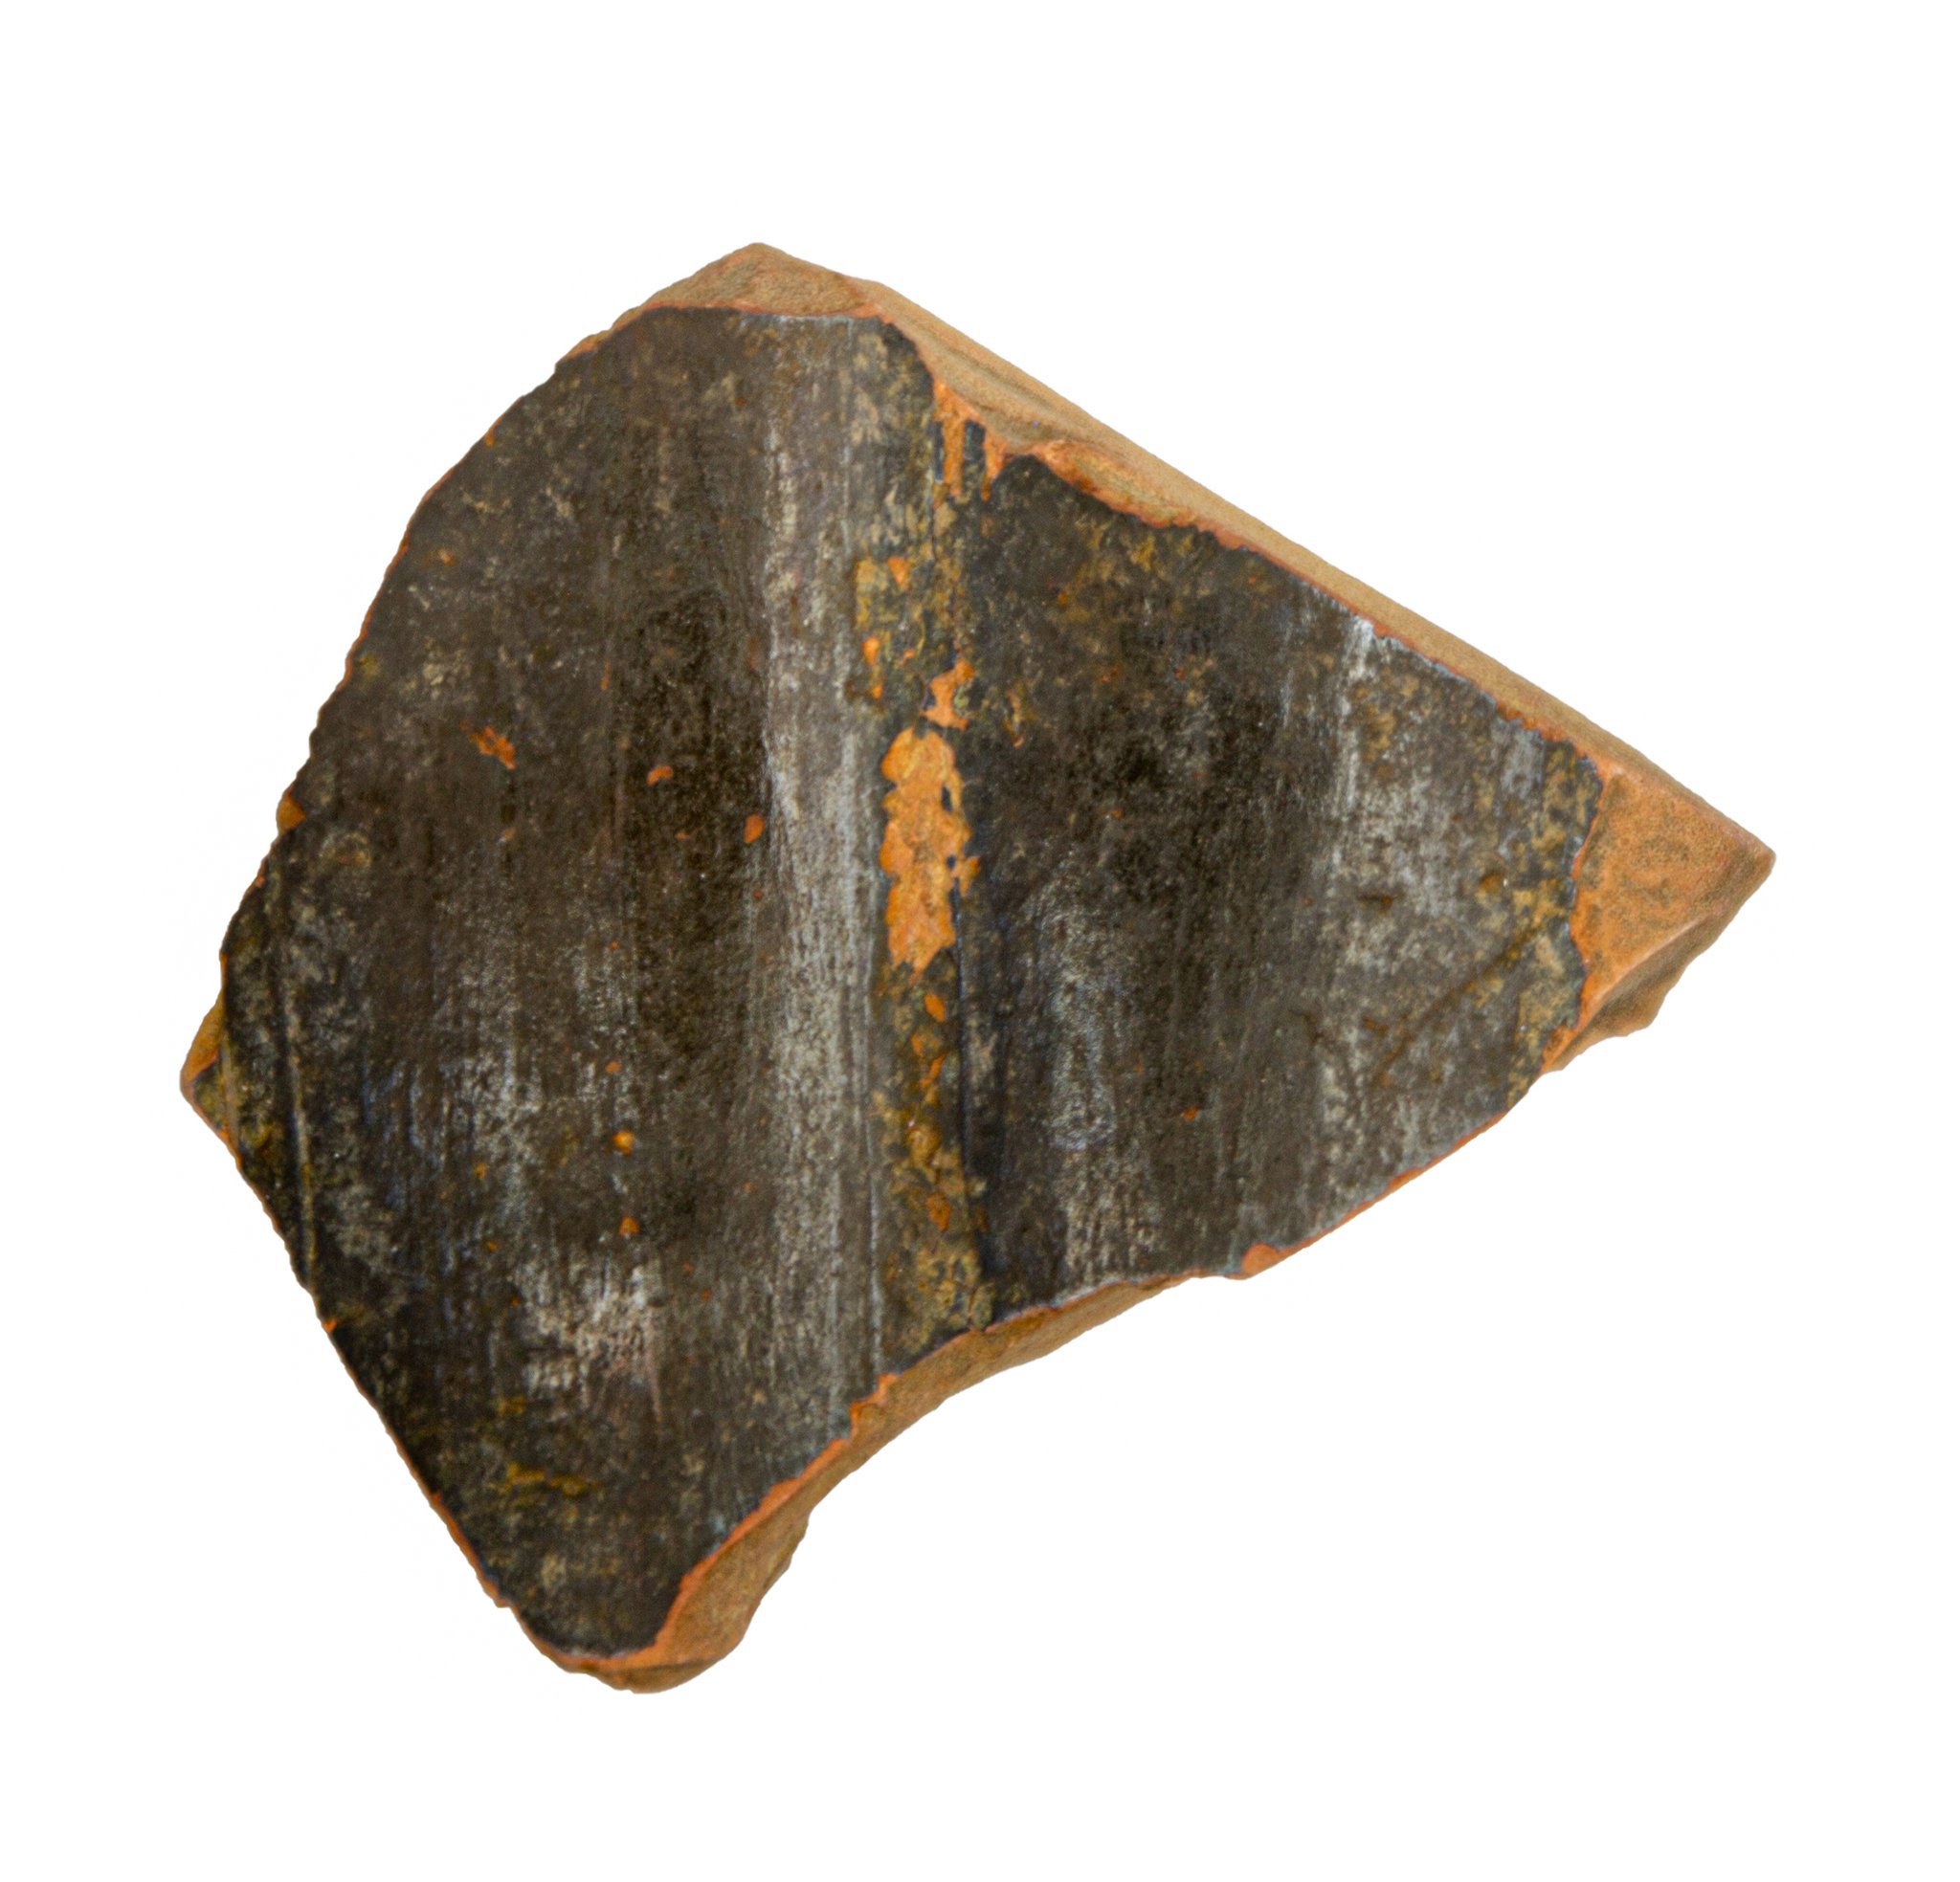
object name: volute krater fragment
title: Volute-krater fragment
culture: greek, south italian, apulian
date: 400-301 BCE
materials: terracotta